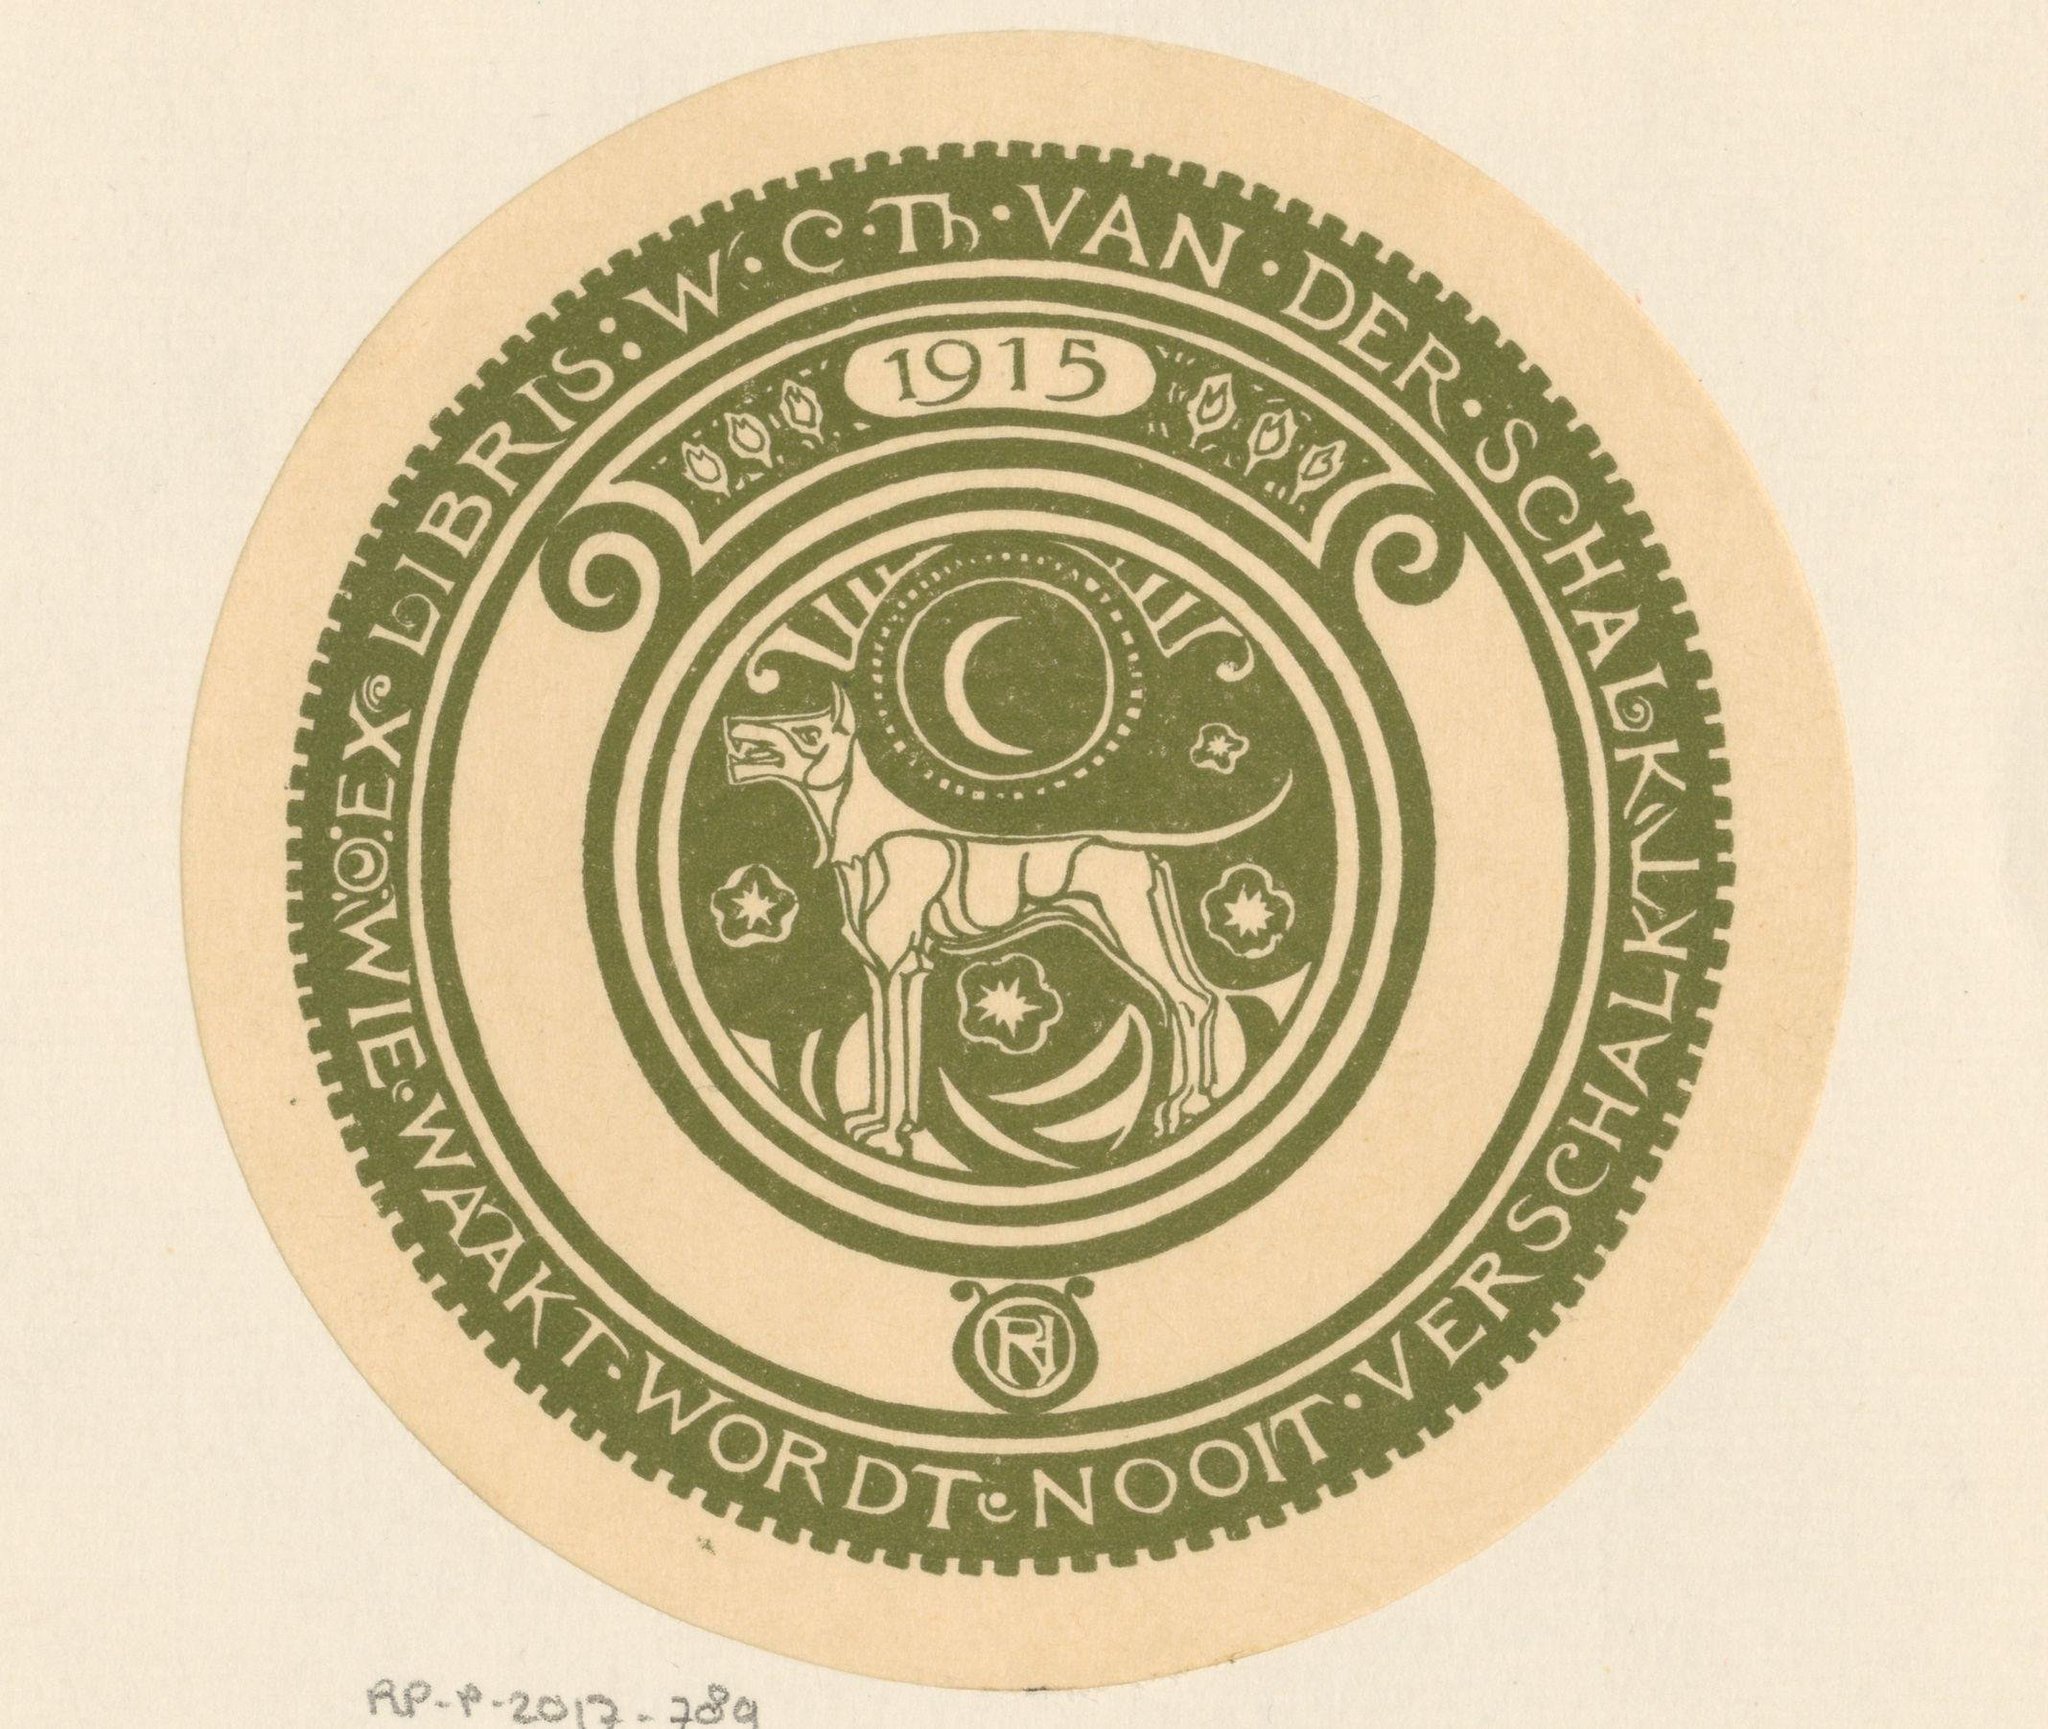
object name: bookplate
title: Ex libris van W.C.Th. van der Schalk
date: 1915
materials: paper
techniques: printing block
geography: netherlands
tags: waning moon, i.e. facing this way (, watch-dog, dog watching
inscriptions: date